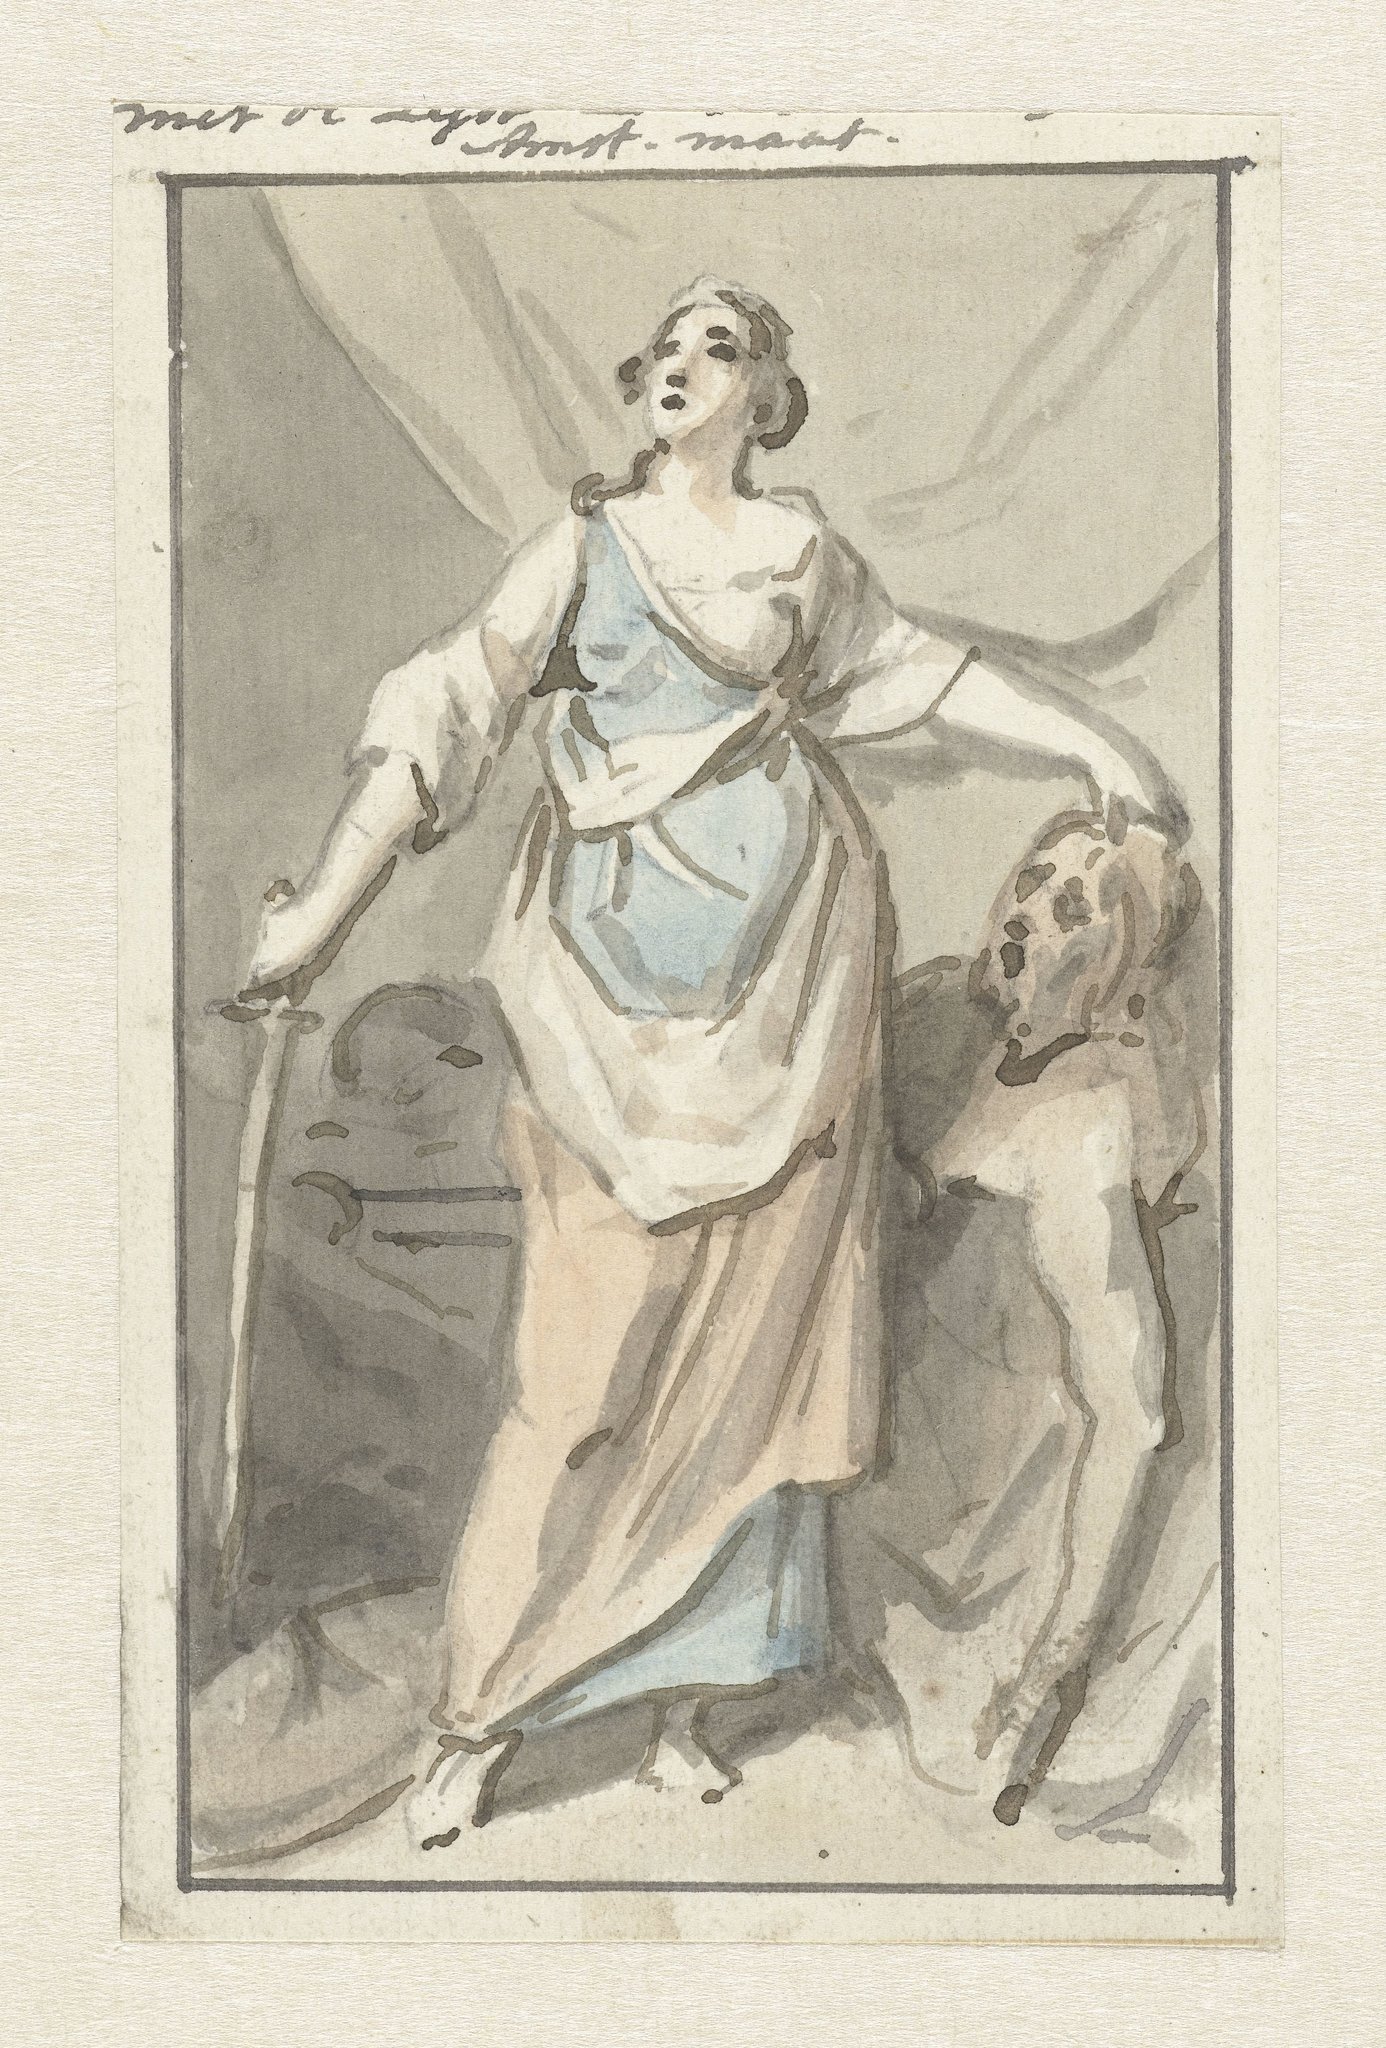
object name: drawing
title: Judith met het hoofd van Holofernes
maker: jurriaan andriessen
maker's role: draughtsman, painter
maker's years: 1742-1819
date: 1752-1819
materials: graphite, ink, paper, watercolor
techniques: brush, pen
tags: judith with holofernes' head and the sword, picture, painting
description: Judith met het hoofd van Holofernes (naar schilderij?)